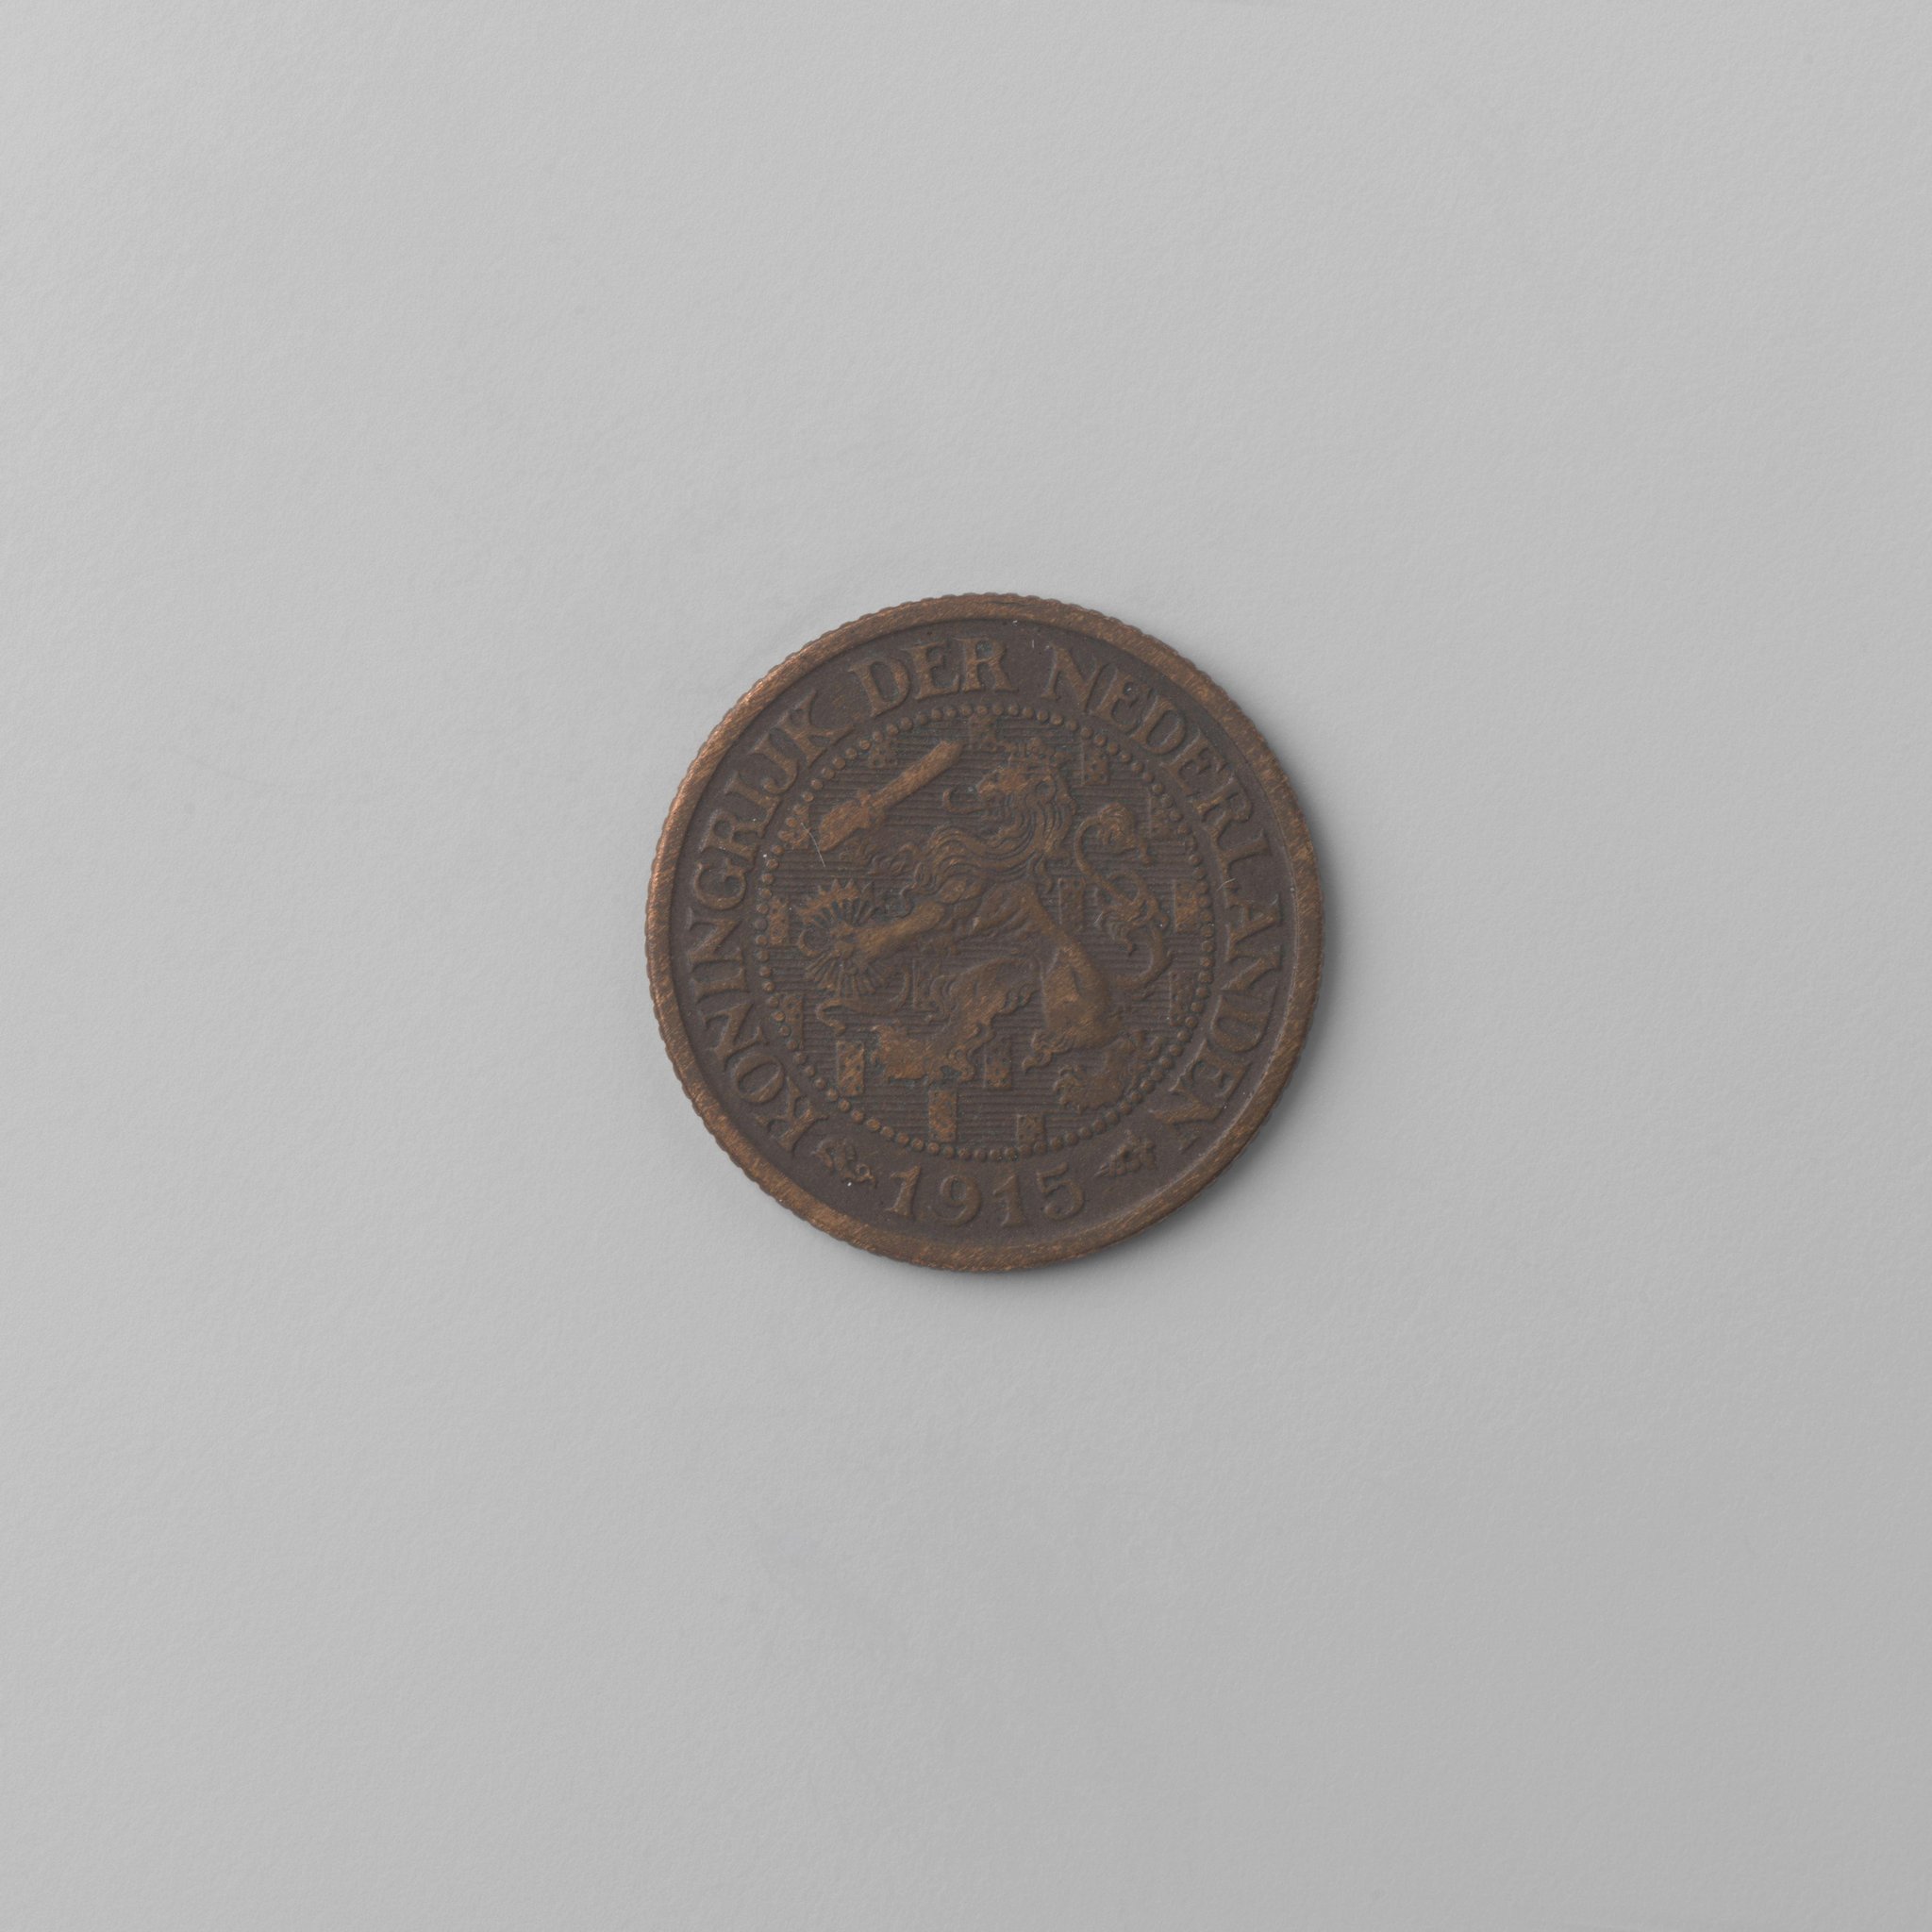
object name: coin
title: Nederlandse cent,1915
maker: wilhelmina of the netherlands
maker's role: print maker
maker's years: 1880-1962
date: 1915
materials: bronze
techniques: striking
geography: utrecht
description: Bronzen munt. Voorzijde: in een veld rijkswapen. Jaartal onderaan in omschrift. Keerzijde: binnen twee samengebonden oranjetakken waarde-aanduiding 1 cent. Kartelrand.